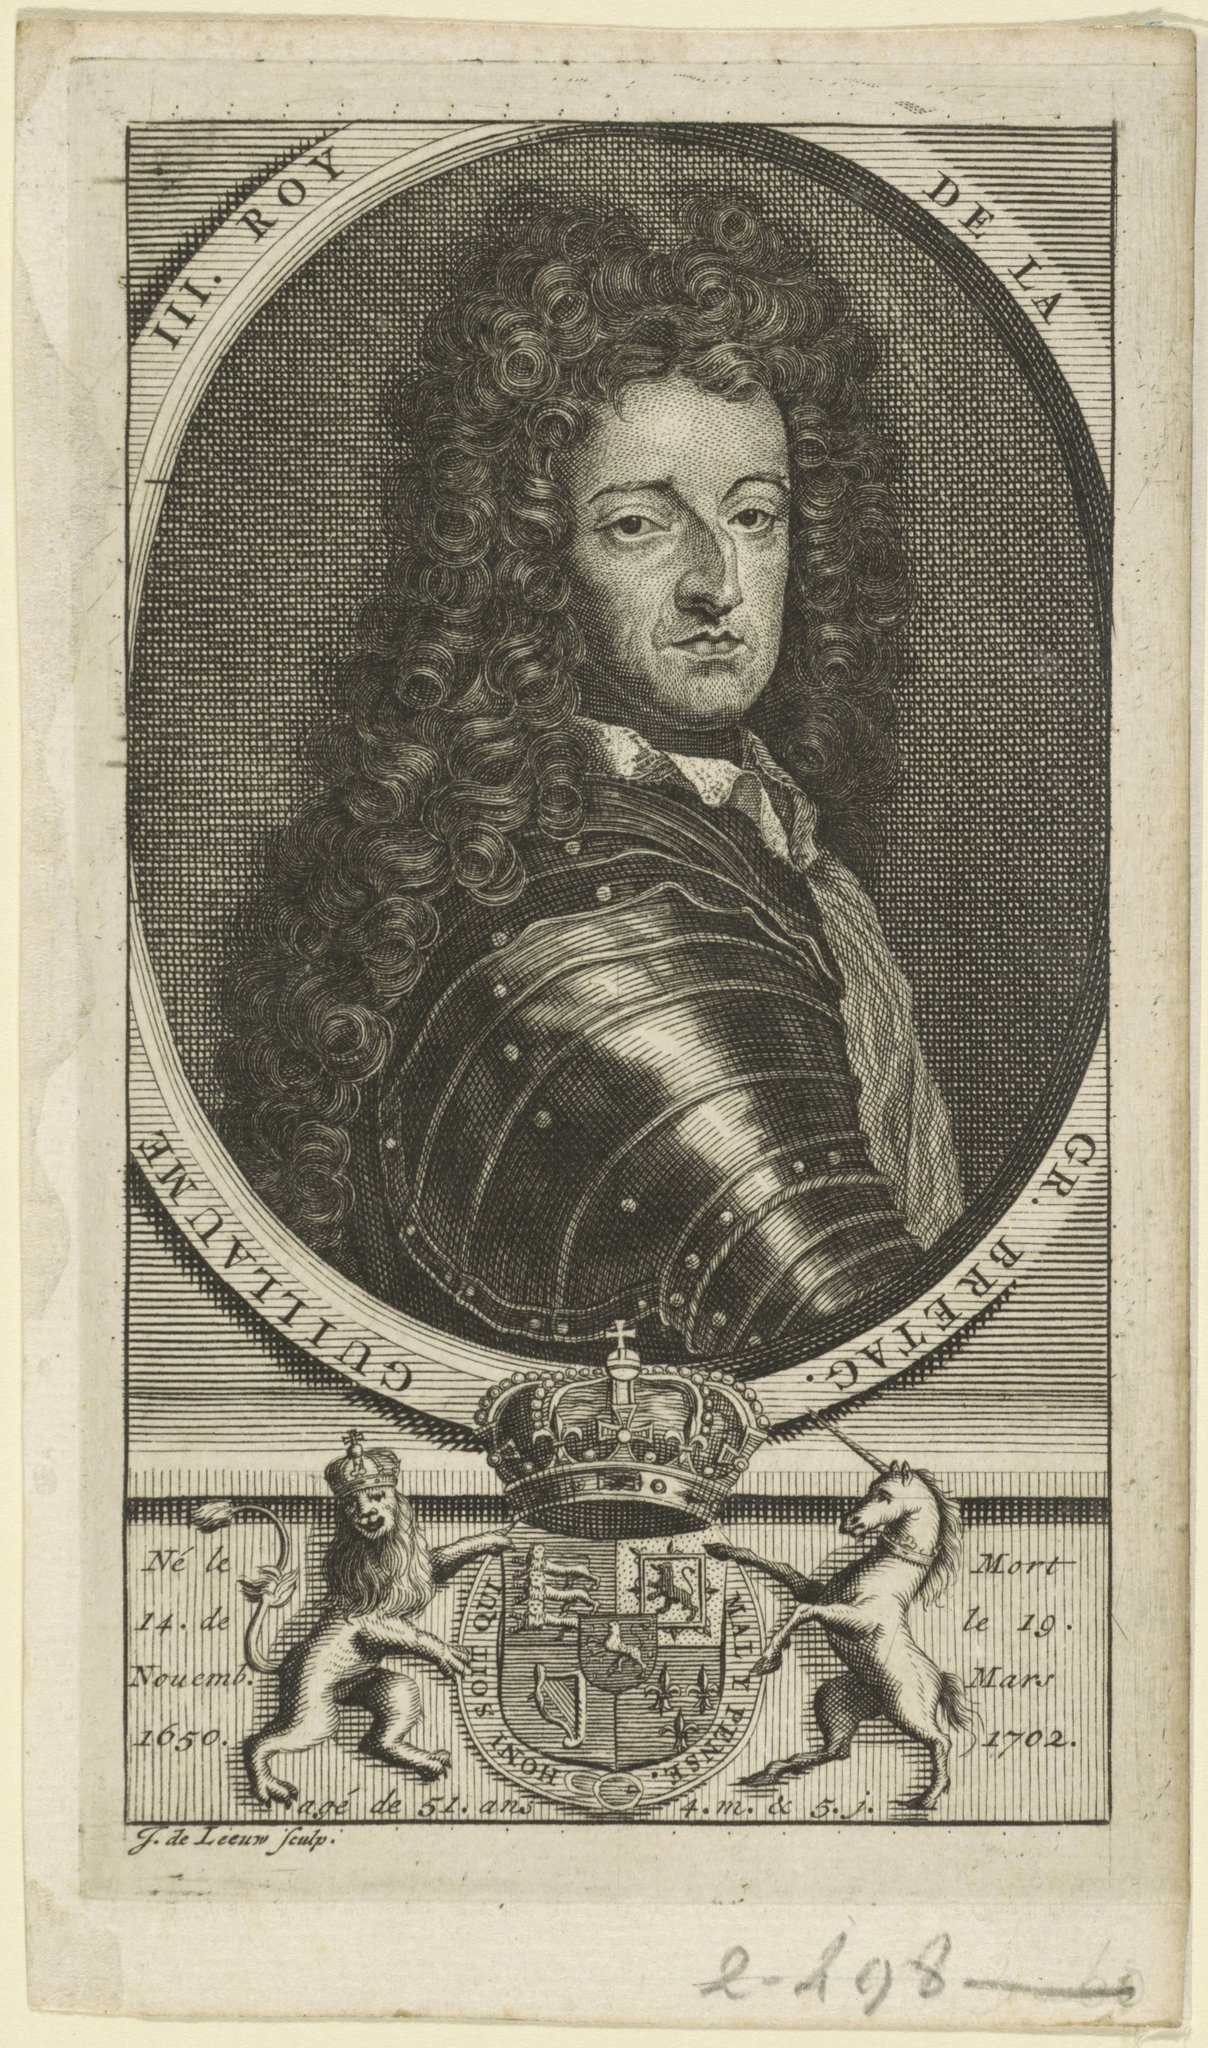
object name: print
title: Portret van Willem III, prins van Oranje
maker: jan de leeuw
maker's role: print maker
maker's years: 1660-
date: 1702-1714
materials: paper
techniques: engraving, etching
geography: the hague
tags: william iii (prince of orange and king of england, scotland, and ireland), knighthood order (garter) - insignia of a knighthood order, e.g.: badge, chain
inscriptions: collector's mark: Lugt 963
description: Portret van Willem III in een ovaal met randschrift. Midden onder zijn wapen met een kroon, een leeuw en een eenhoorn, gedecoreerd met de Kousenband en het devies van de Orde van de Kousenband. In een kader zijn geboortedatum, sterfdatum en leeftijd in het Frans.